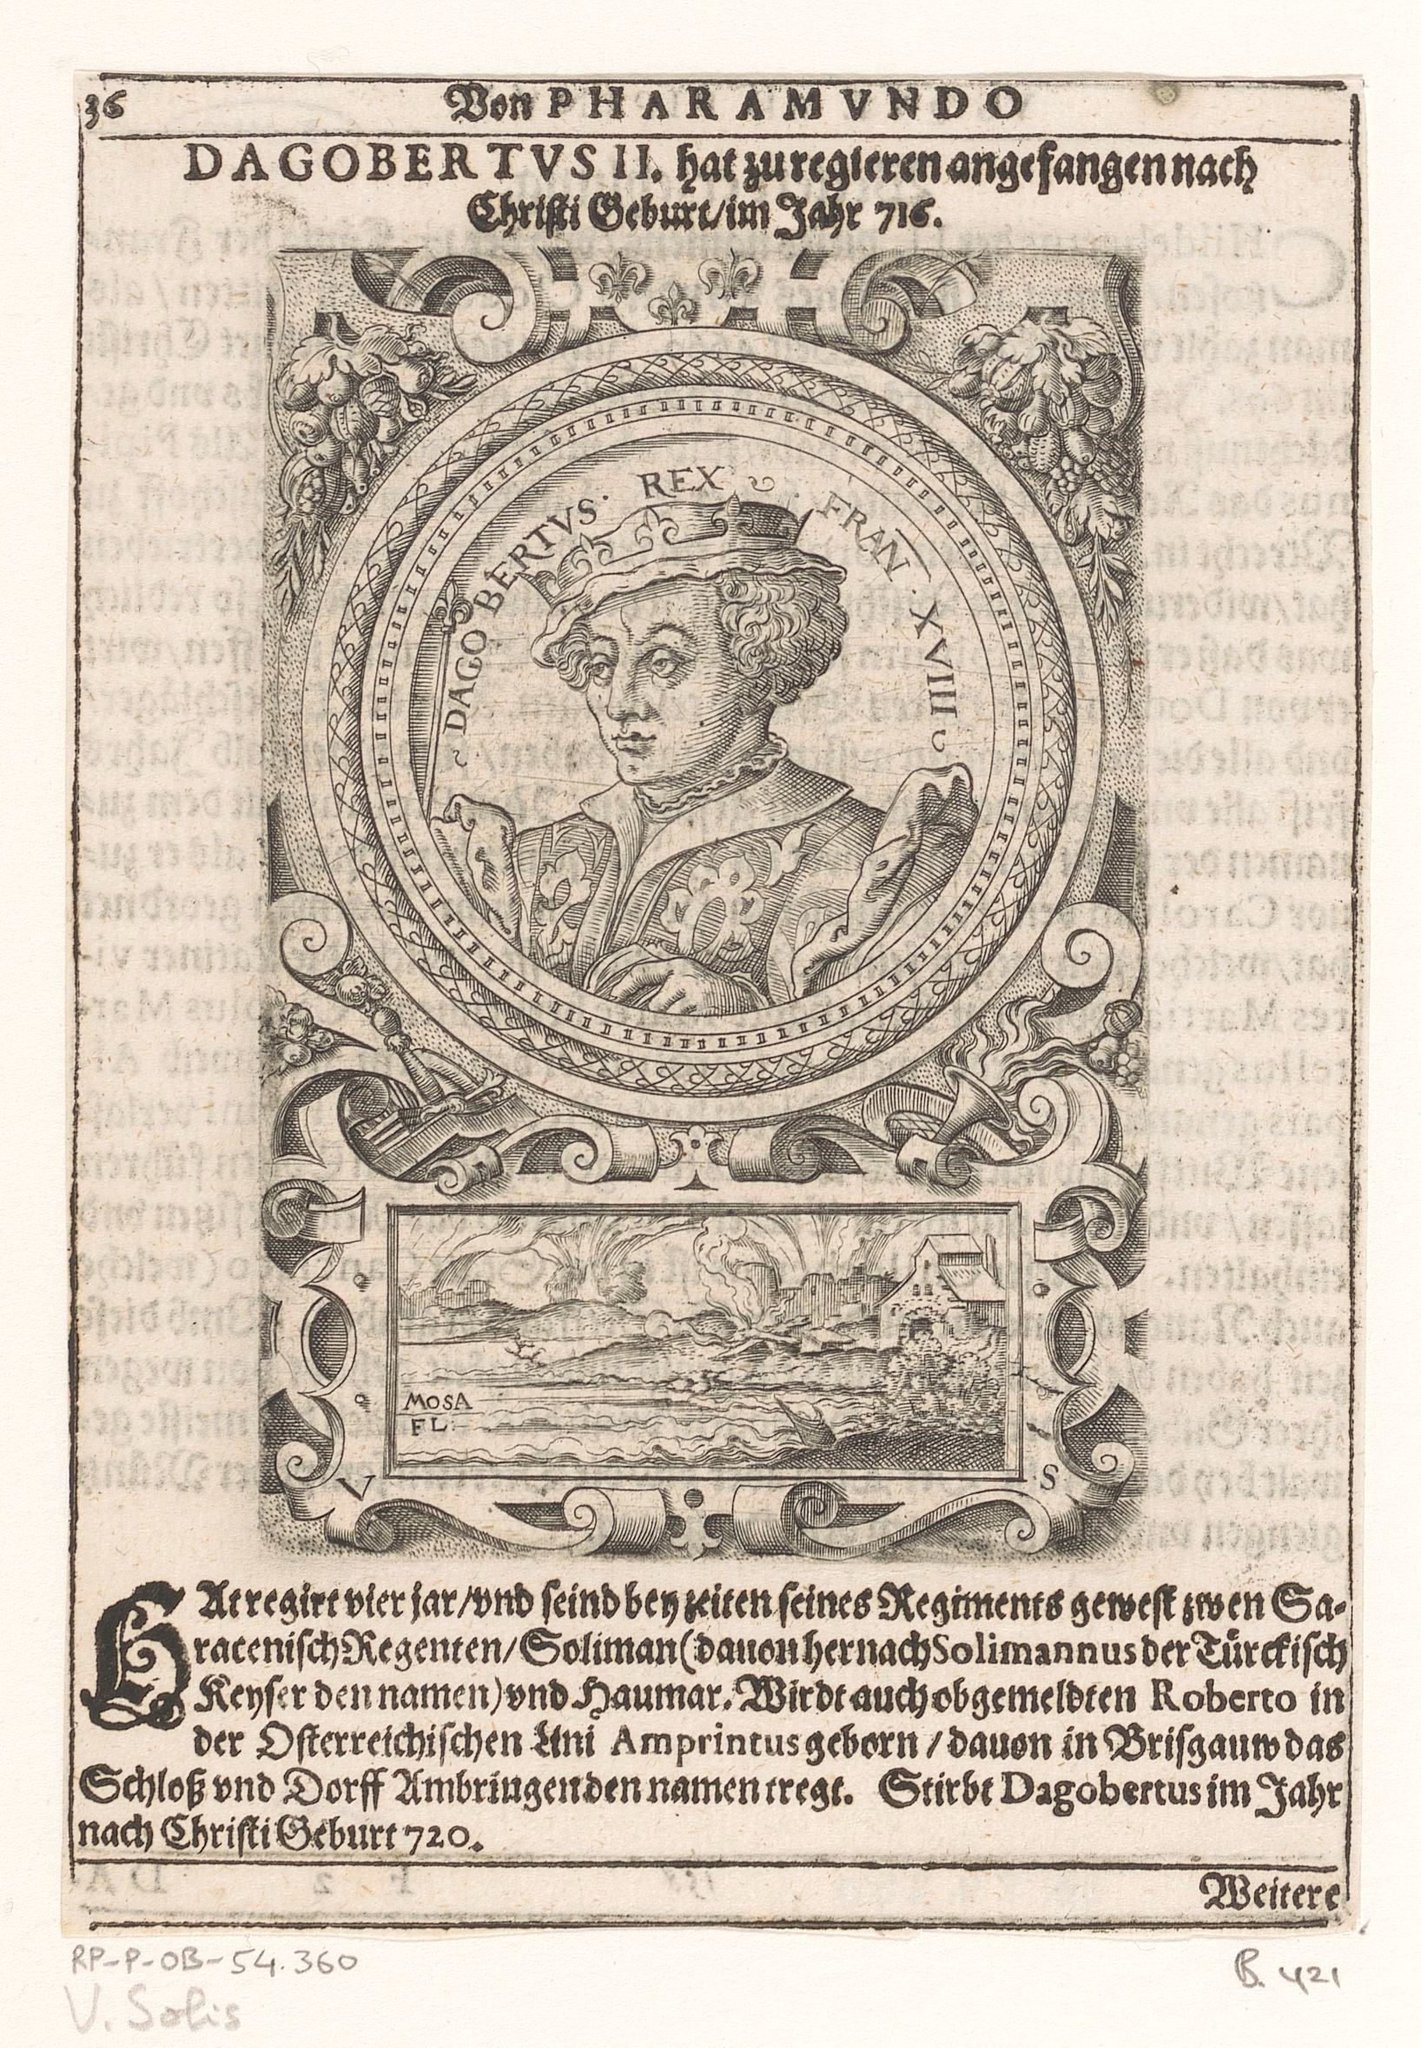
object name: print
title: Portret van Dagobert III, koning der Franken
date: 1598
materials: paper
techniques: engraving, etching, intaglio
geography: nuremberg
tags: scrollwork, strapwork ~ ornament, historical persons, ruler, sovereign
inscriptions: collector's mark: Lugt 2228, number: ‘158’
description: Prent afkomstig uit de publicatie: Michael Eizinger. Könige in Frankreich. Keulen: Johann Bussemacher, 1598, p. 36. De publicatie bevat prenten van Jost Amman en Virgil Solis.